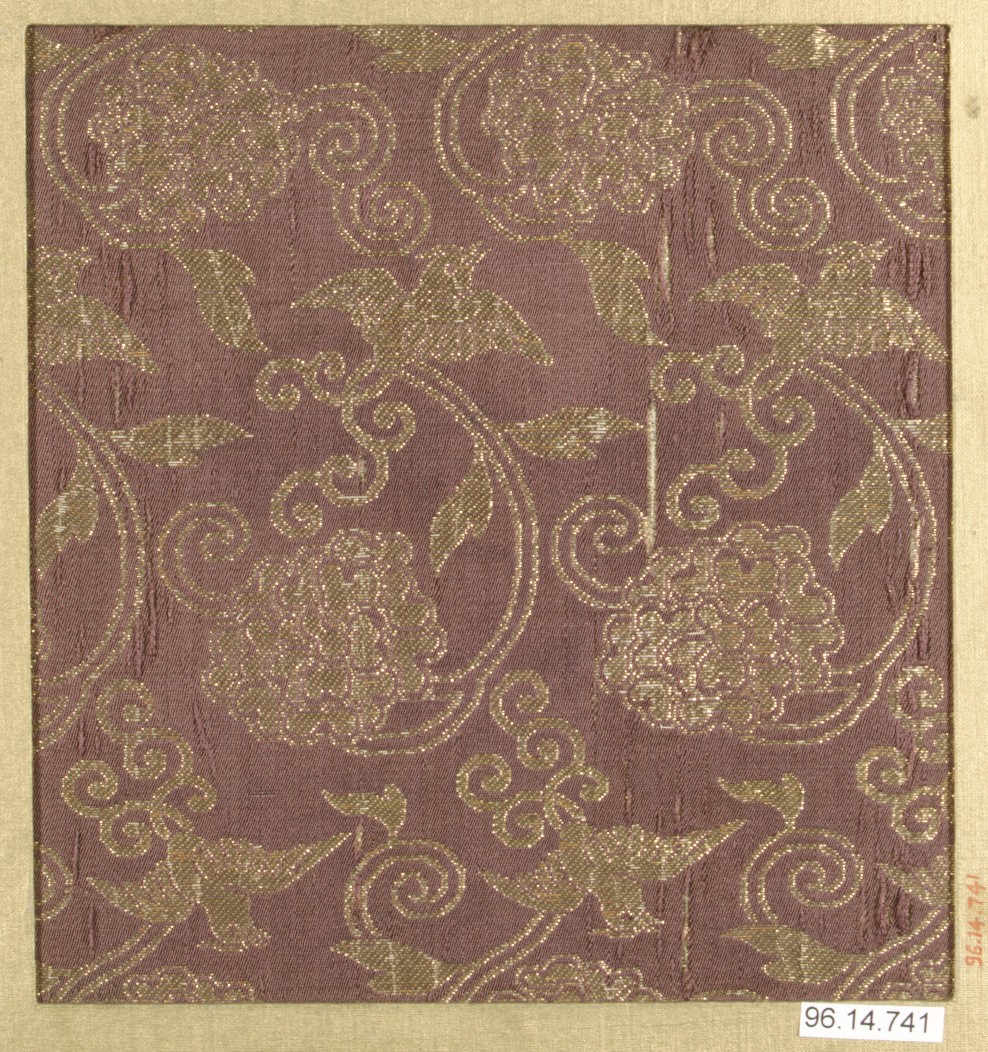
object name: piece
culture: japanese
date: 1701-1900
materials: silk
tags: flowers,leaves